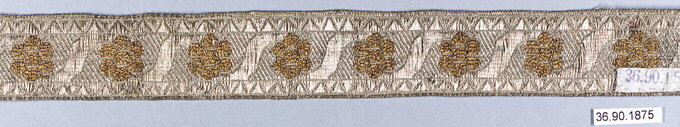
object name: galloon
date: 1767-1833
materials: metal thread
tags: flowers